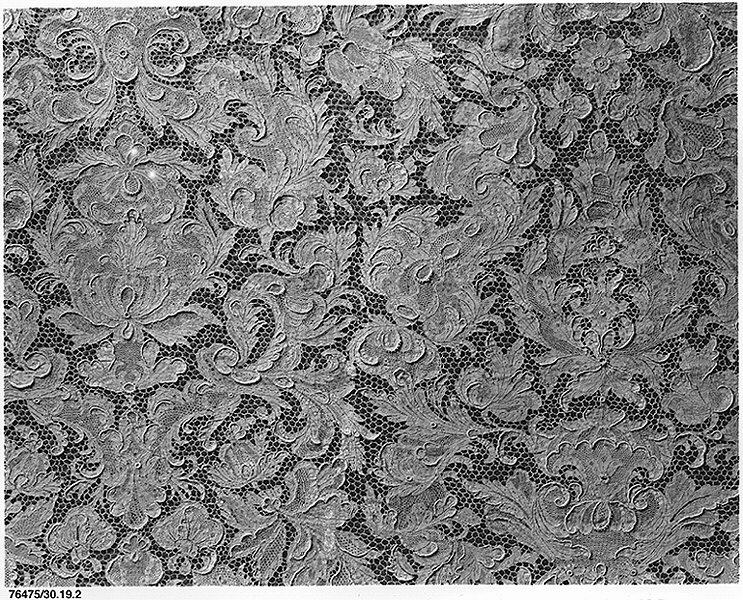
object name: flounce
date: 1701-1733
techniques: lace